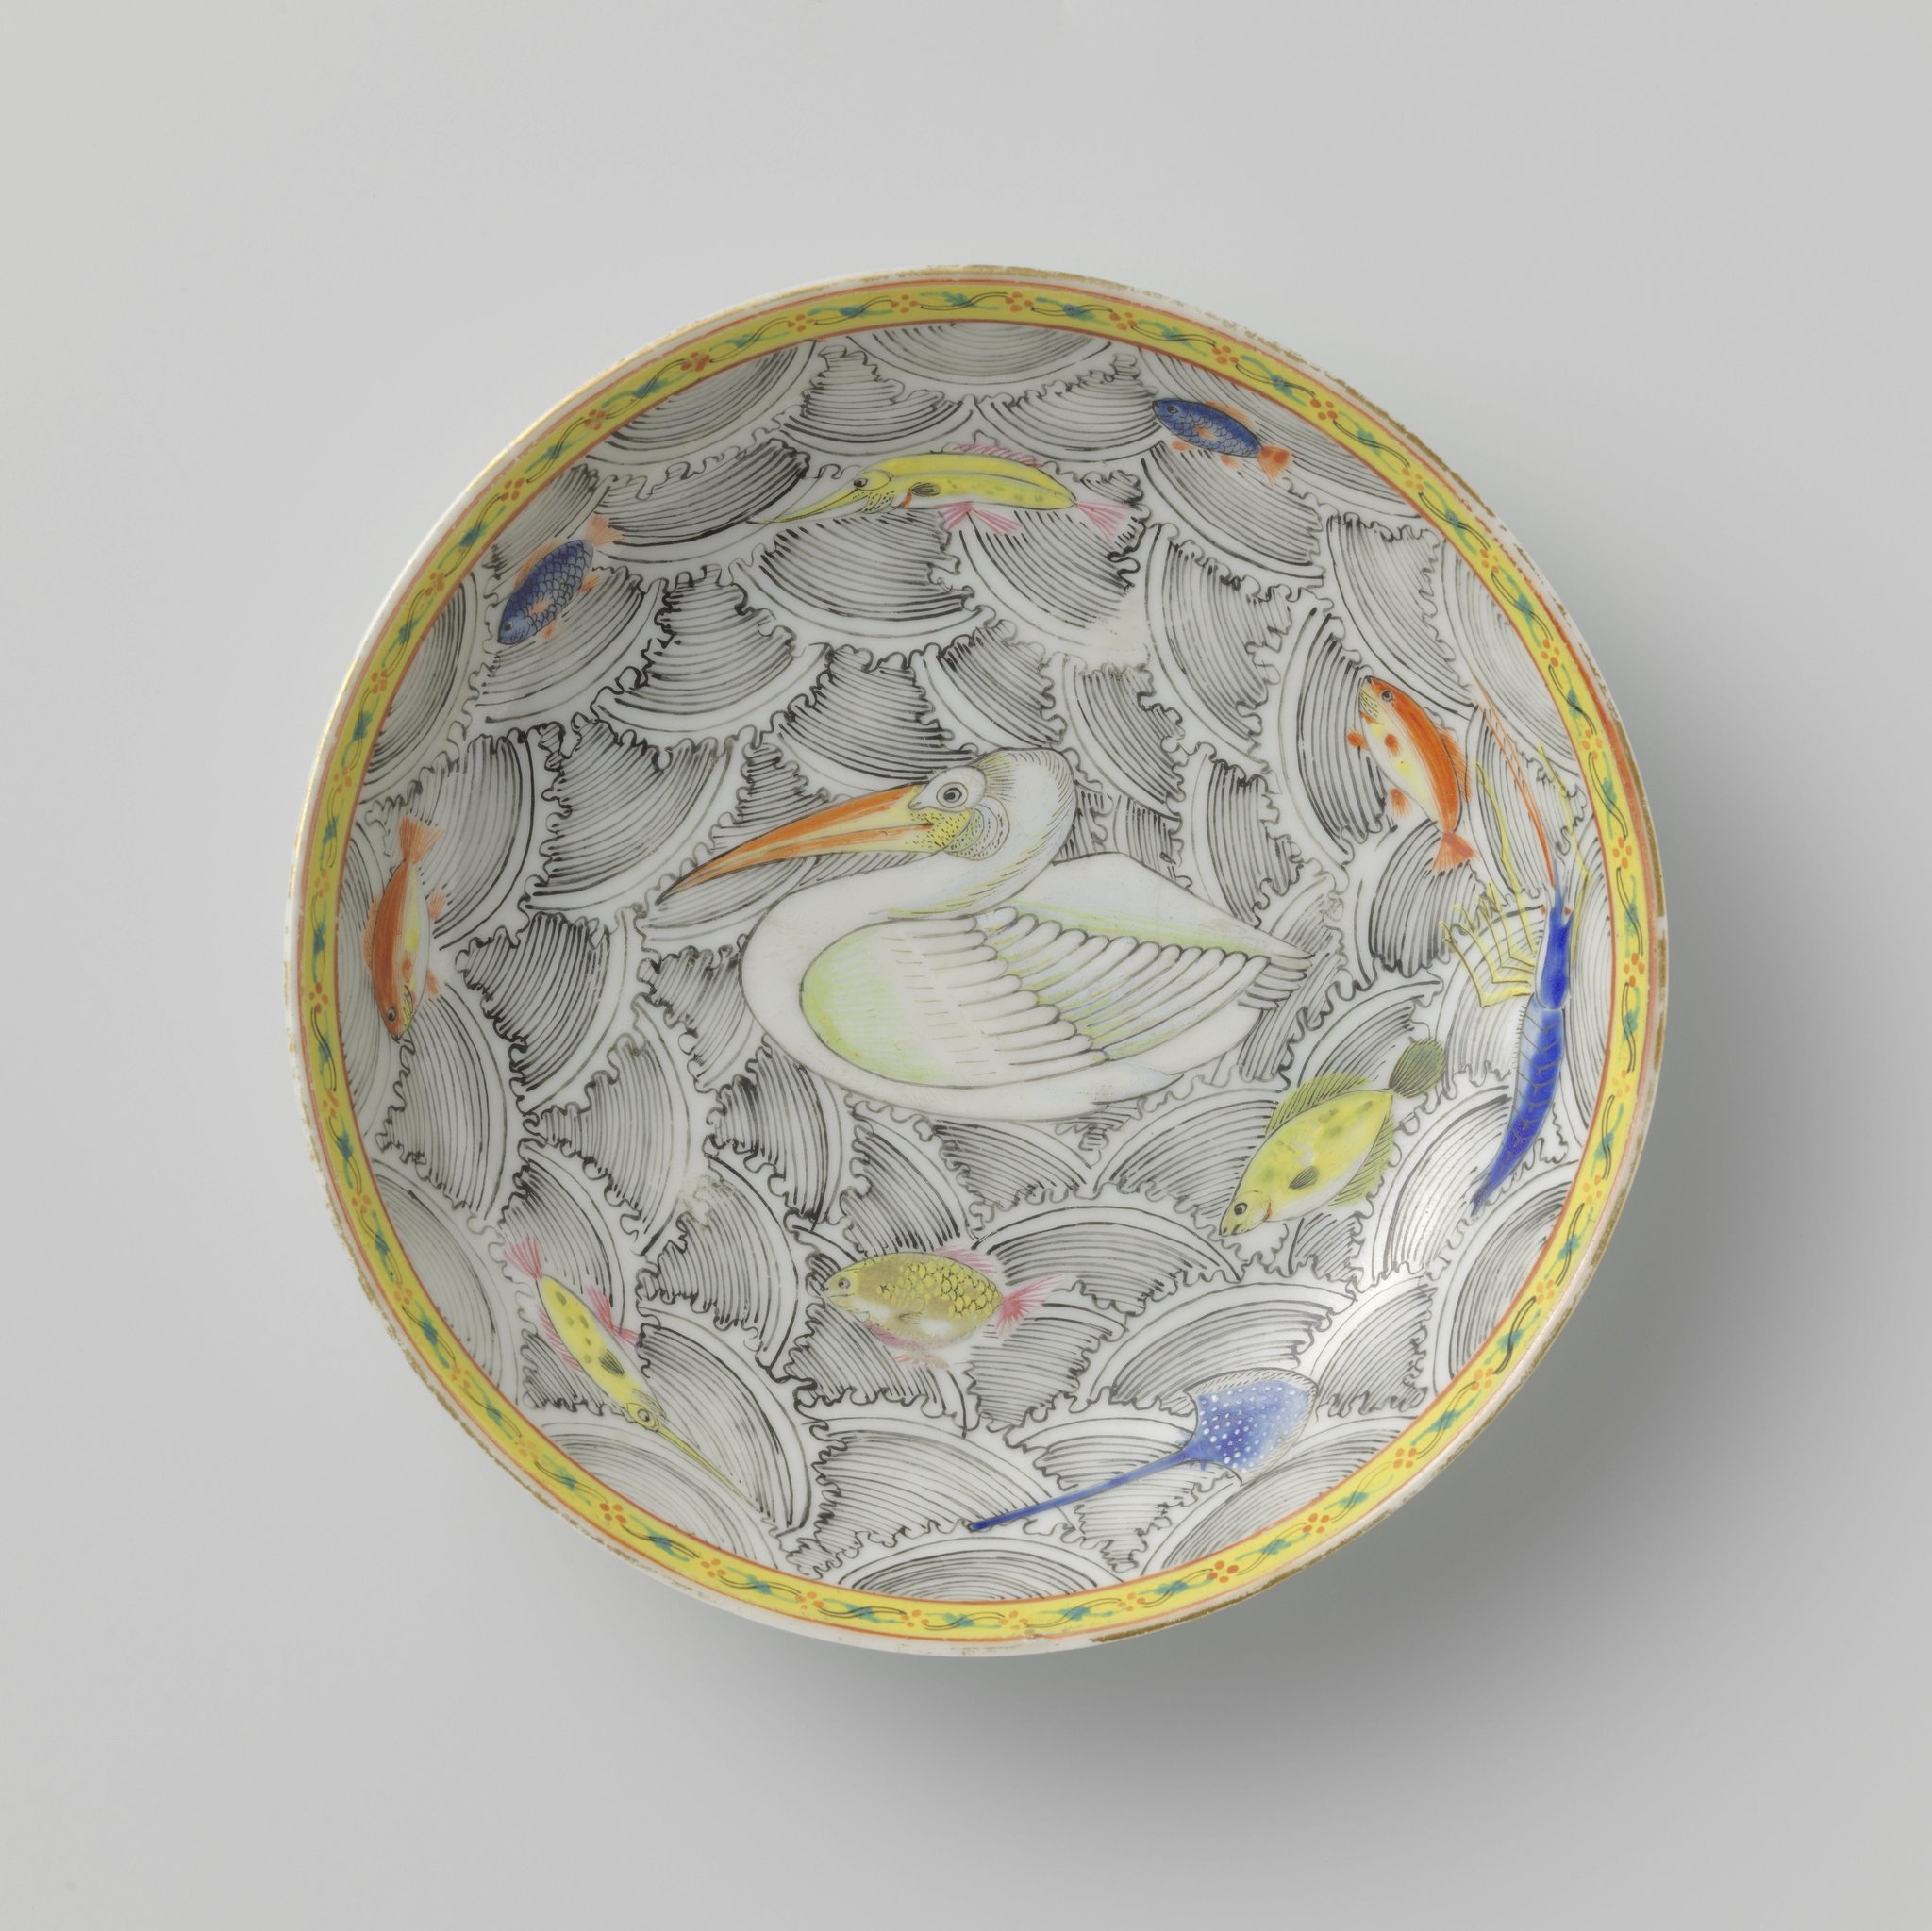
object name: platter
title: Saucer with pelican and fish amid stylized waves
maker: Anonymous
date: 1850-1899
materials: glaze, gold, paint, porcelain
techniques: firing, gilding, turning, vitrification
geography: china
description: Schotel van porselein, beschilderd op het glazuur in blauw, rood, roze, groen, geel, zwart en goud. Op het plat een pelikaan, verschillende soorten vis en een garnaal tussen gestileerde golven; de binnenrand met een decoratief patroon op een gele grond. Famille rose.